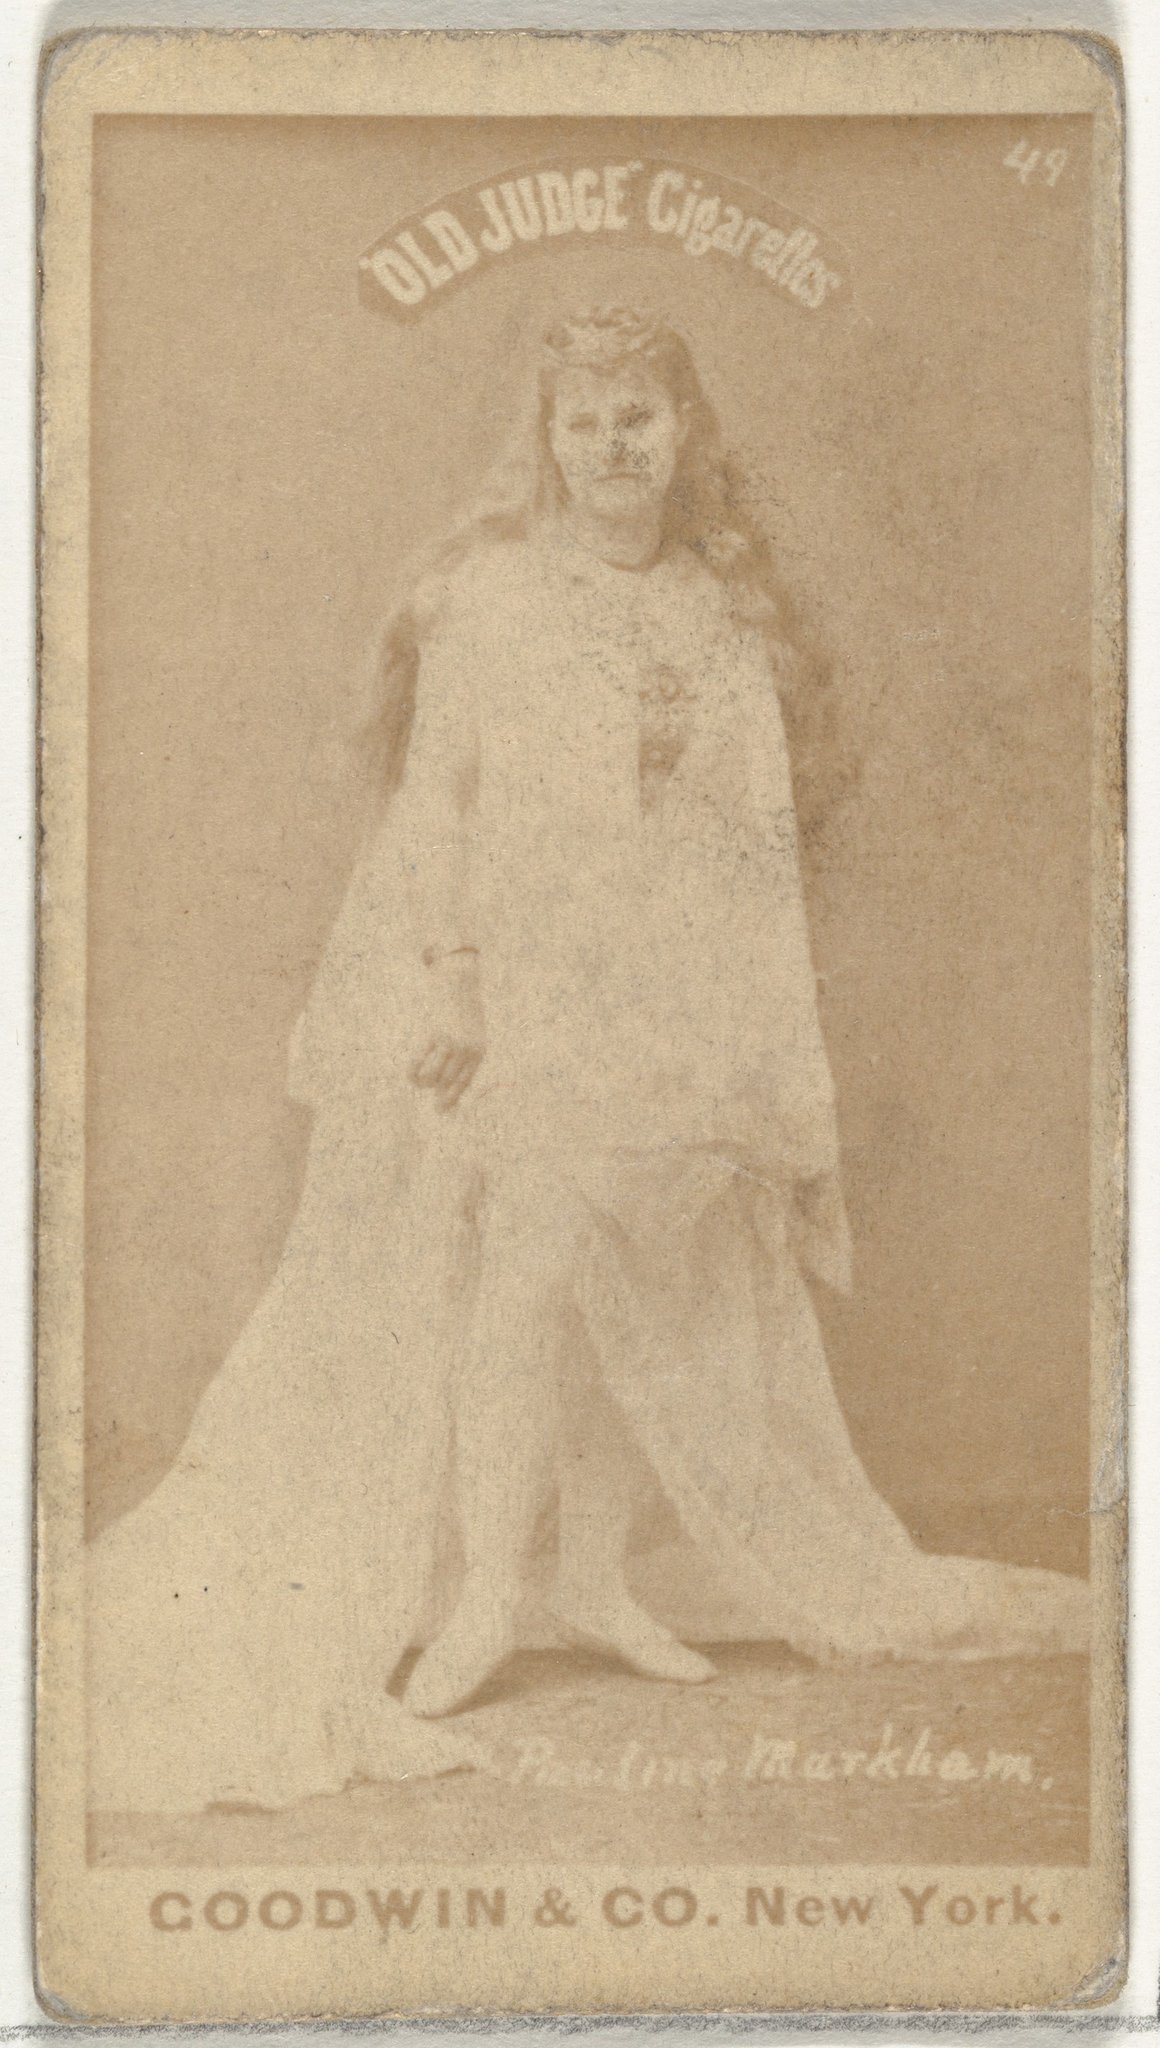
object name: photograph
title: Pauline Markham, from the Actors and Actresses series (N171) for Old Judge Cigarettes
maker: goodwin & company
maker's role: publisher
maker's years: 1850-1950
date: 1886-1890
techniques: albumen silver print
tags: portraits,women,actresses